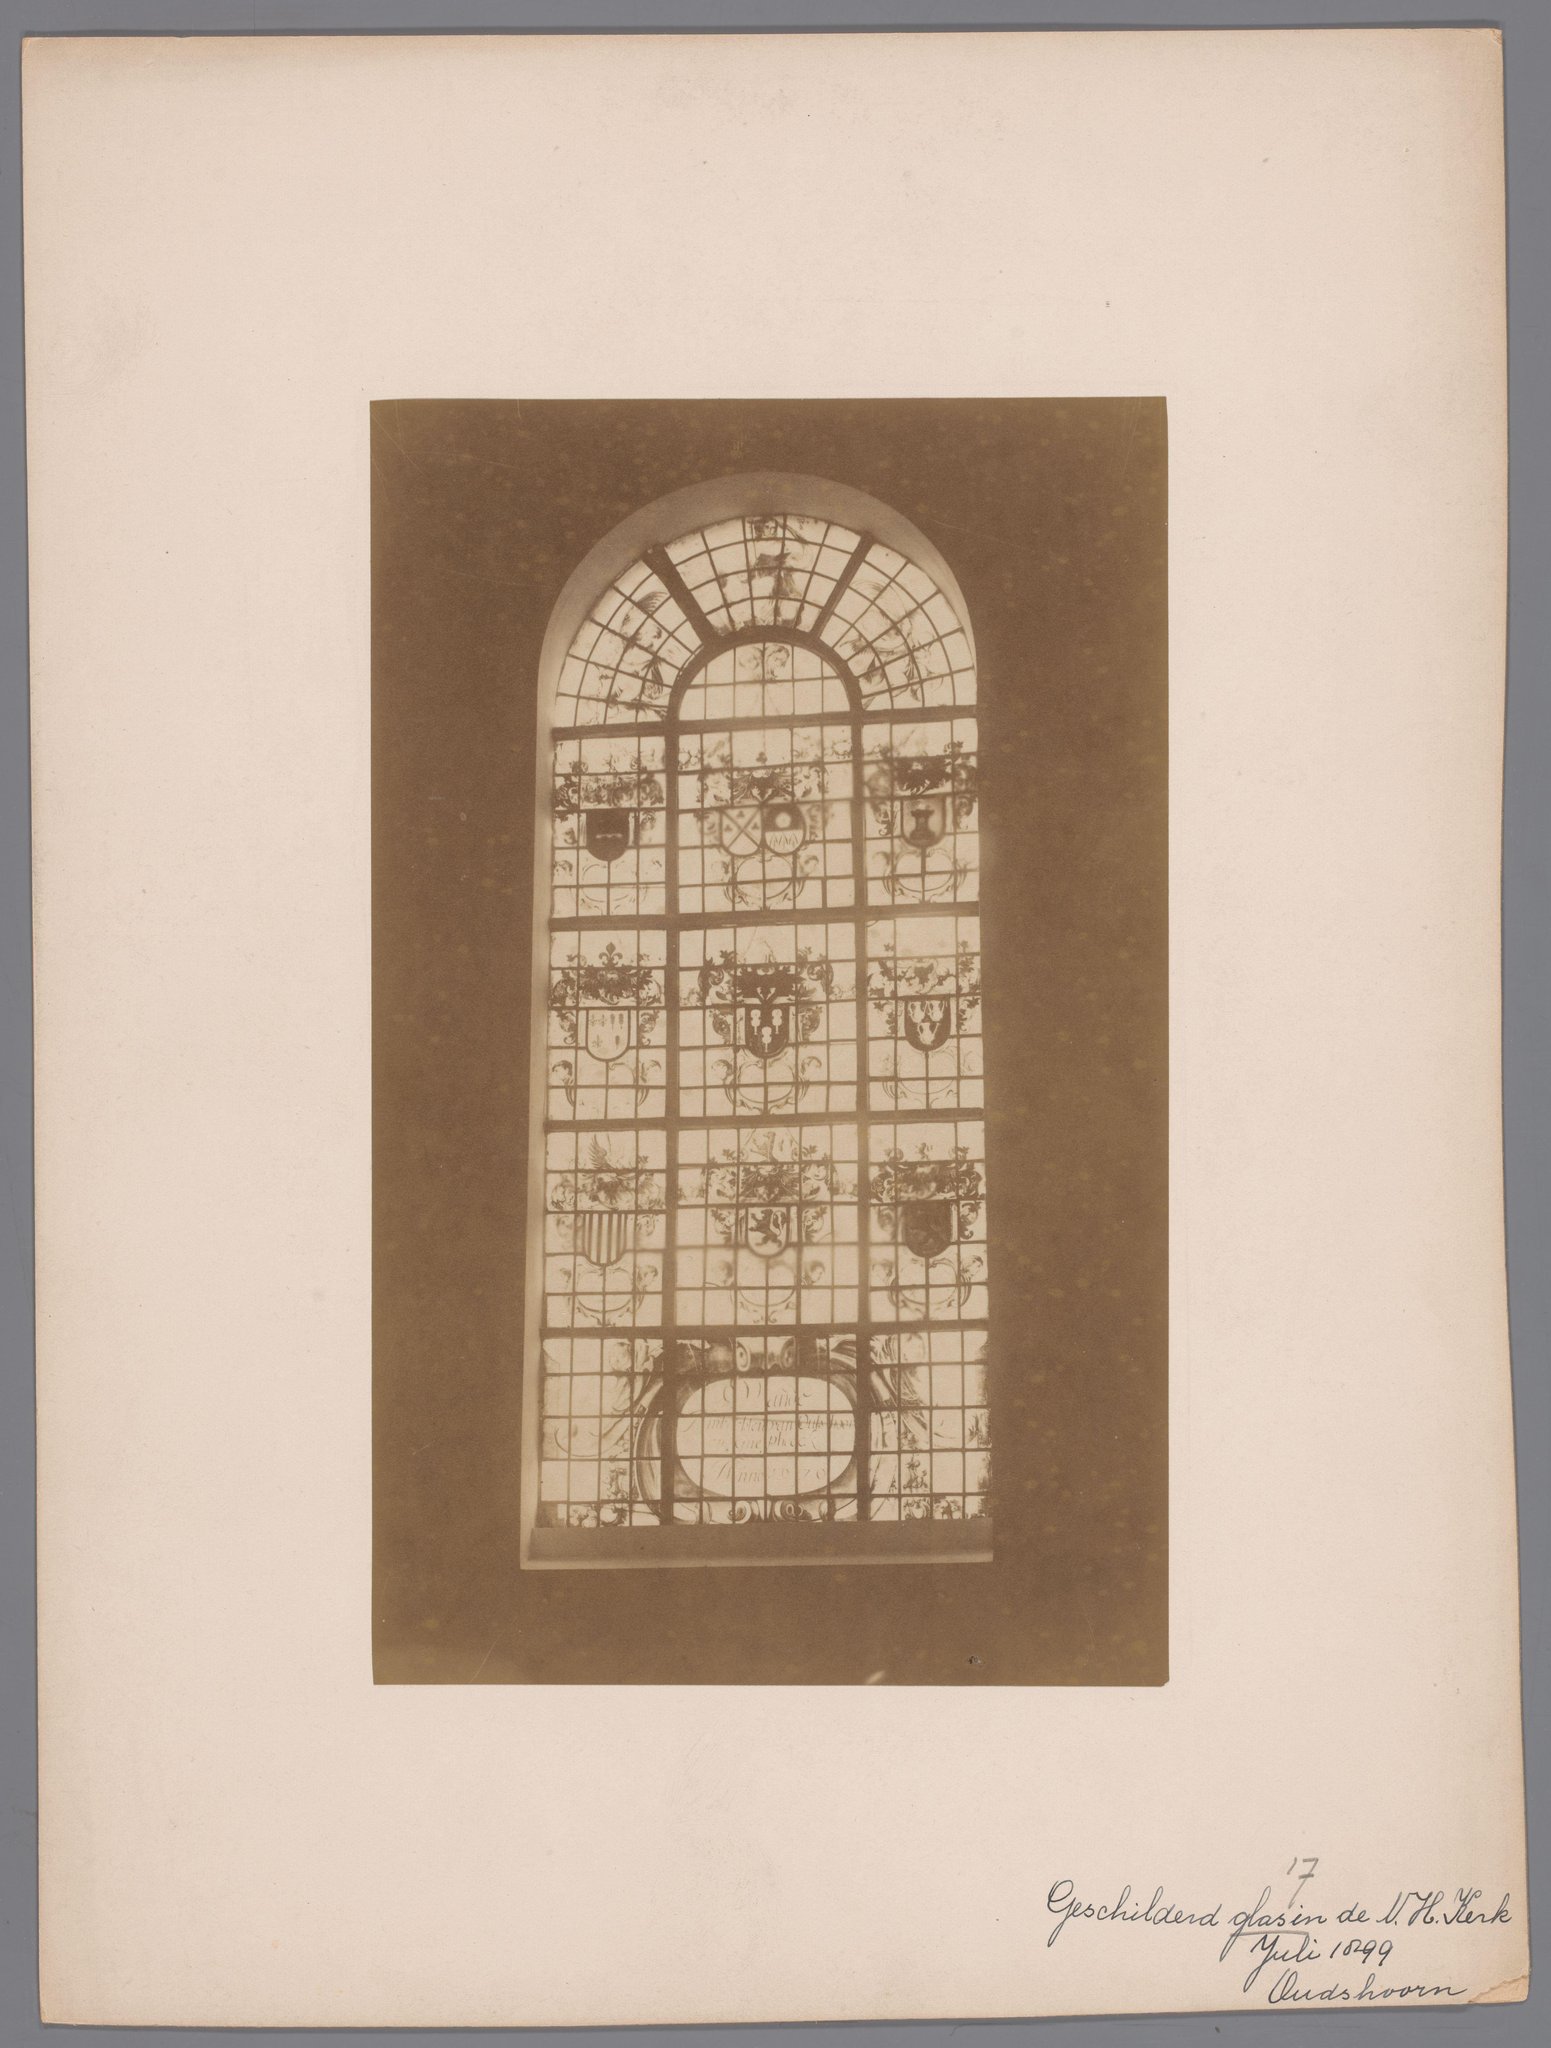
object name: photograph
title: Geschilderd raam in de Oudshoornse Kerk te Oudshoorn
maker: anoniem (monumentenzorg)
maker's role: fotograaf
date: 1899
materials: cardboard, photographic support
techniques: albumen print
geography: oudshoorn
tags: church-window, e.g. rose-window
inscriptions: annotation: ‘Geschilderd glas 17 in de N.H. Kerk/ Juli 1899/ Oudshoorn’, annotation: ‘Geschilderd glas in de kerk te Oudshoorn (Z.H.)/ Juli 1899’